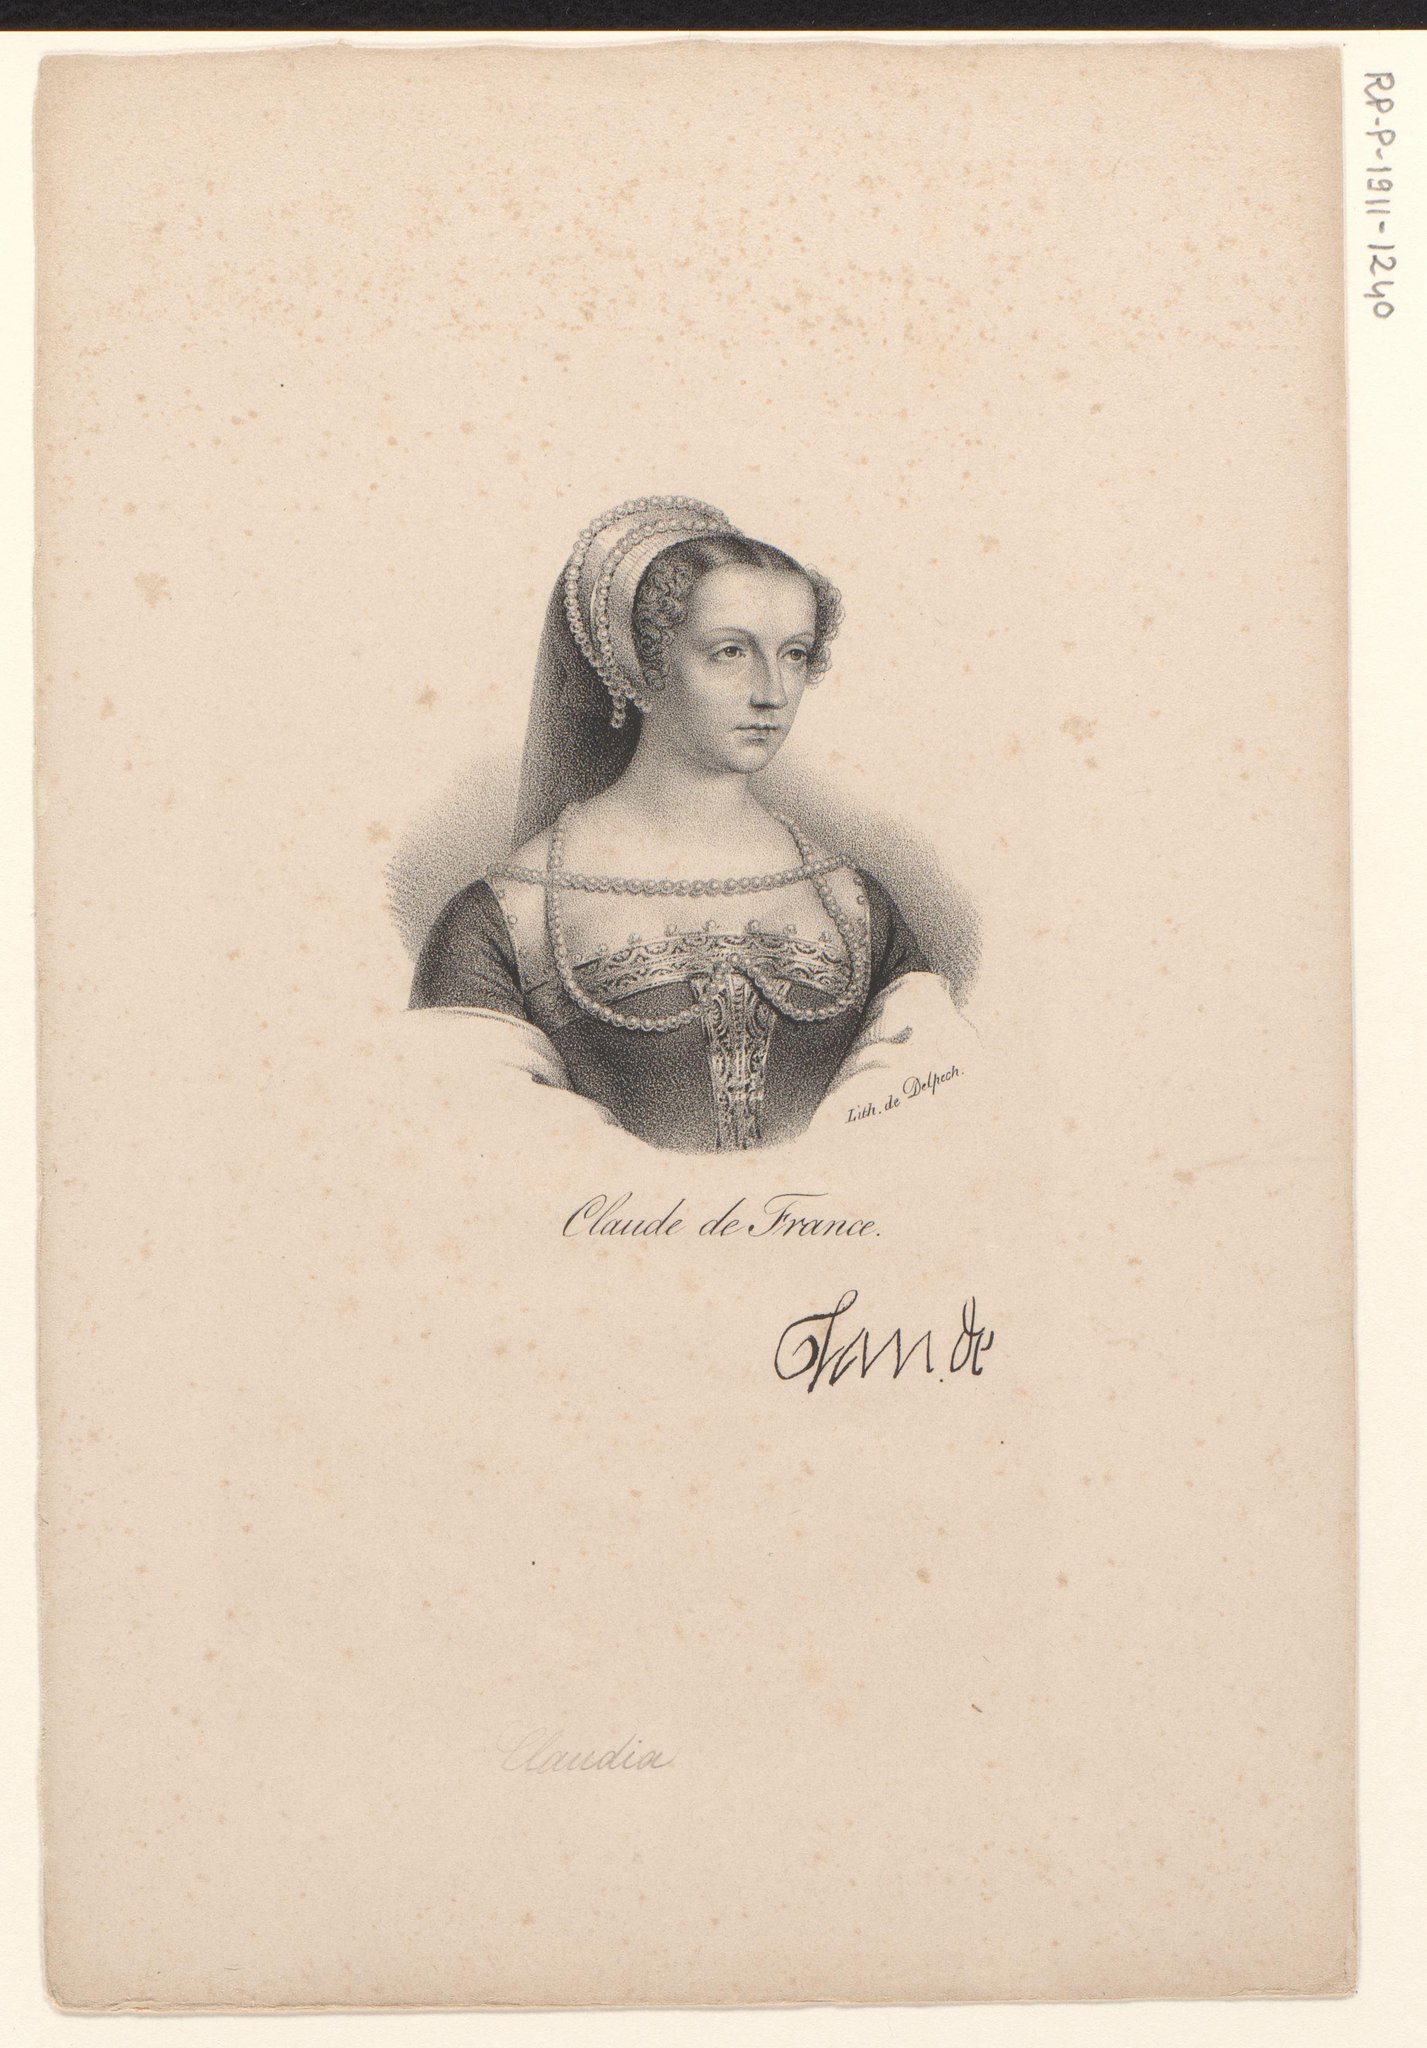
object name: print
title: Claude de France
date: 1818-1842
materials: paper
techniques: lithograph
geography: paris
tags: historical persons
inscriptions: collector's mark: Lugt 2228a